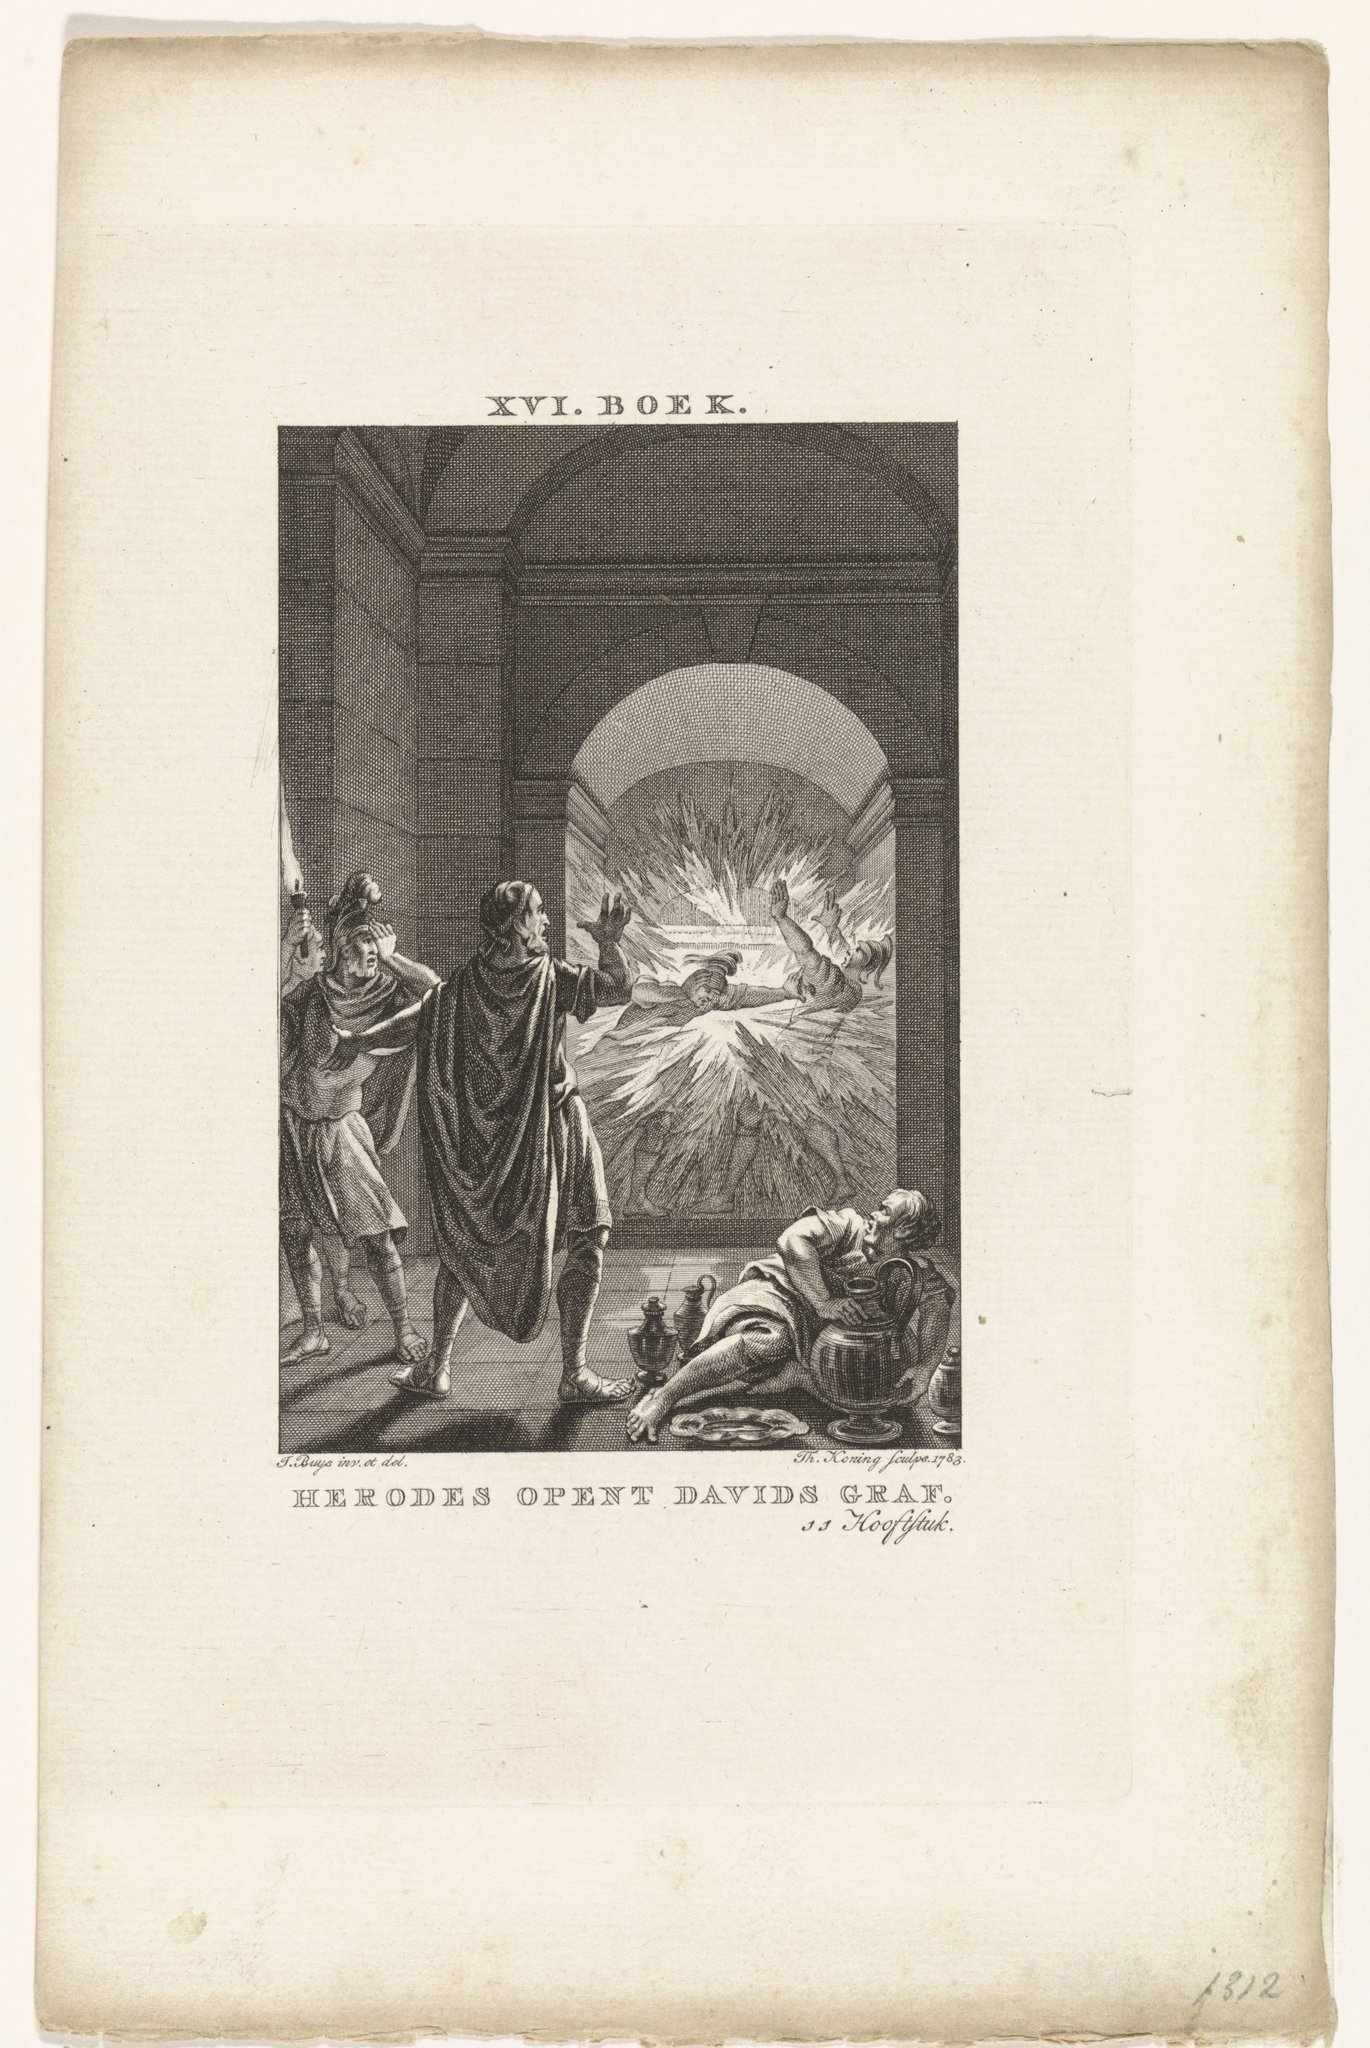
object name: print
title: David's graf voor de tweede keer geopend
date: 1783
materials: paper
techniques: engraving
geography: amsterdam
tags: plundering of david's grave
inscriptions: collector's mark: Lugt 2228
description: Nadat Herodes wat goud- en zilverwerk uit het graf van koning David had gehaald, stuurde hij twee bedienden naar de tombe om de overige waardevolle spullen te halen. Dit kostte beide bedienden het leven omdat er enorme vlammen uit de tombe sloegen die hen verschroeiden. Deze prent is een illustratie bij het elfde hoofdstuk van het zestiende boek van 'Alle de werken van Flavius Josephus'.